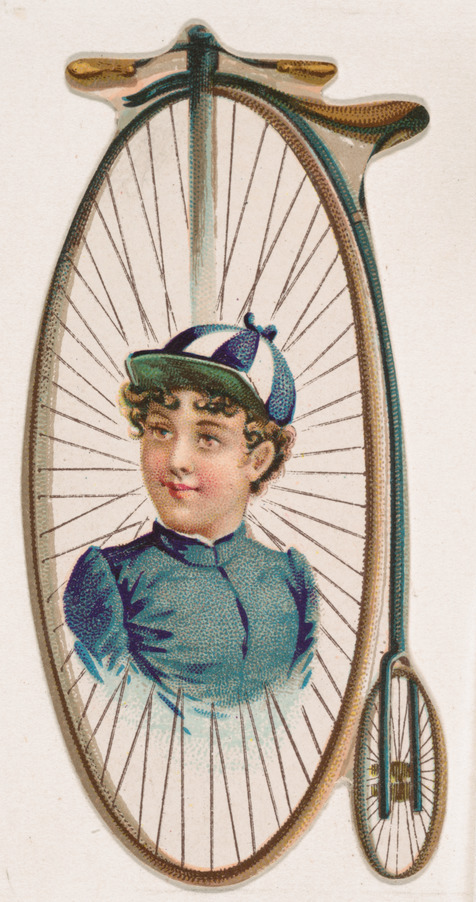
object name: print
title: Bicycle, from the Novelties series (N228, Type 3) issued by Kinney Bros.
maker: kinney brothers tobacco company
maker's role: publisher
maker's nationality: american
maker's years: 1869-2011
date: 1889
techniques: color lithograph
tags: women,bicycles